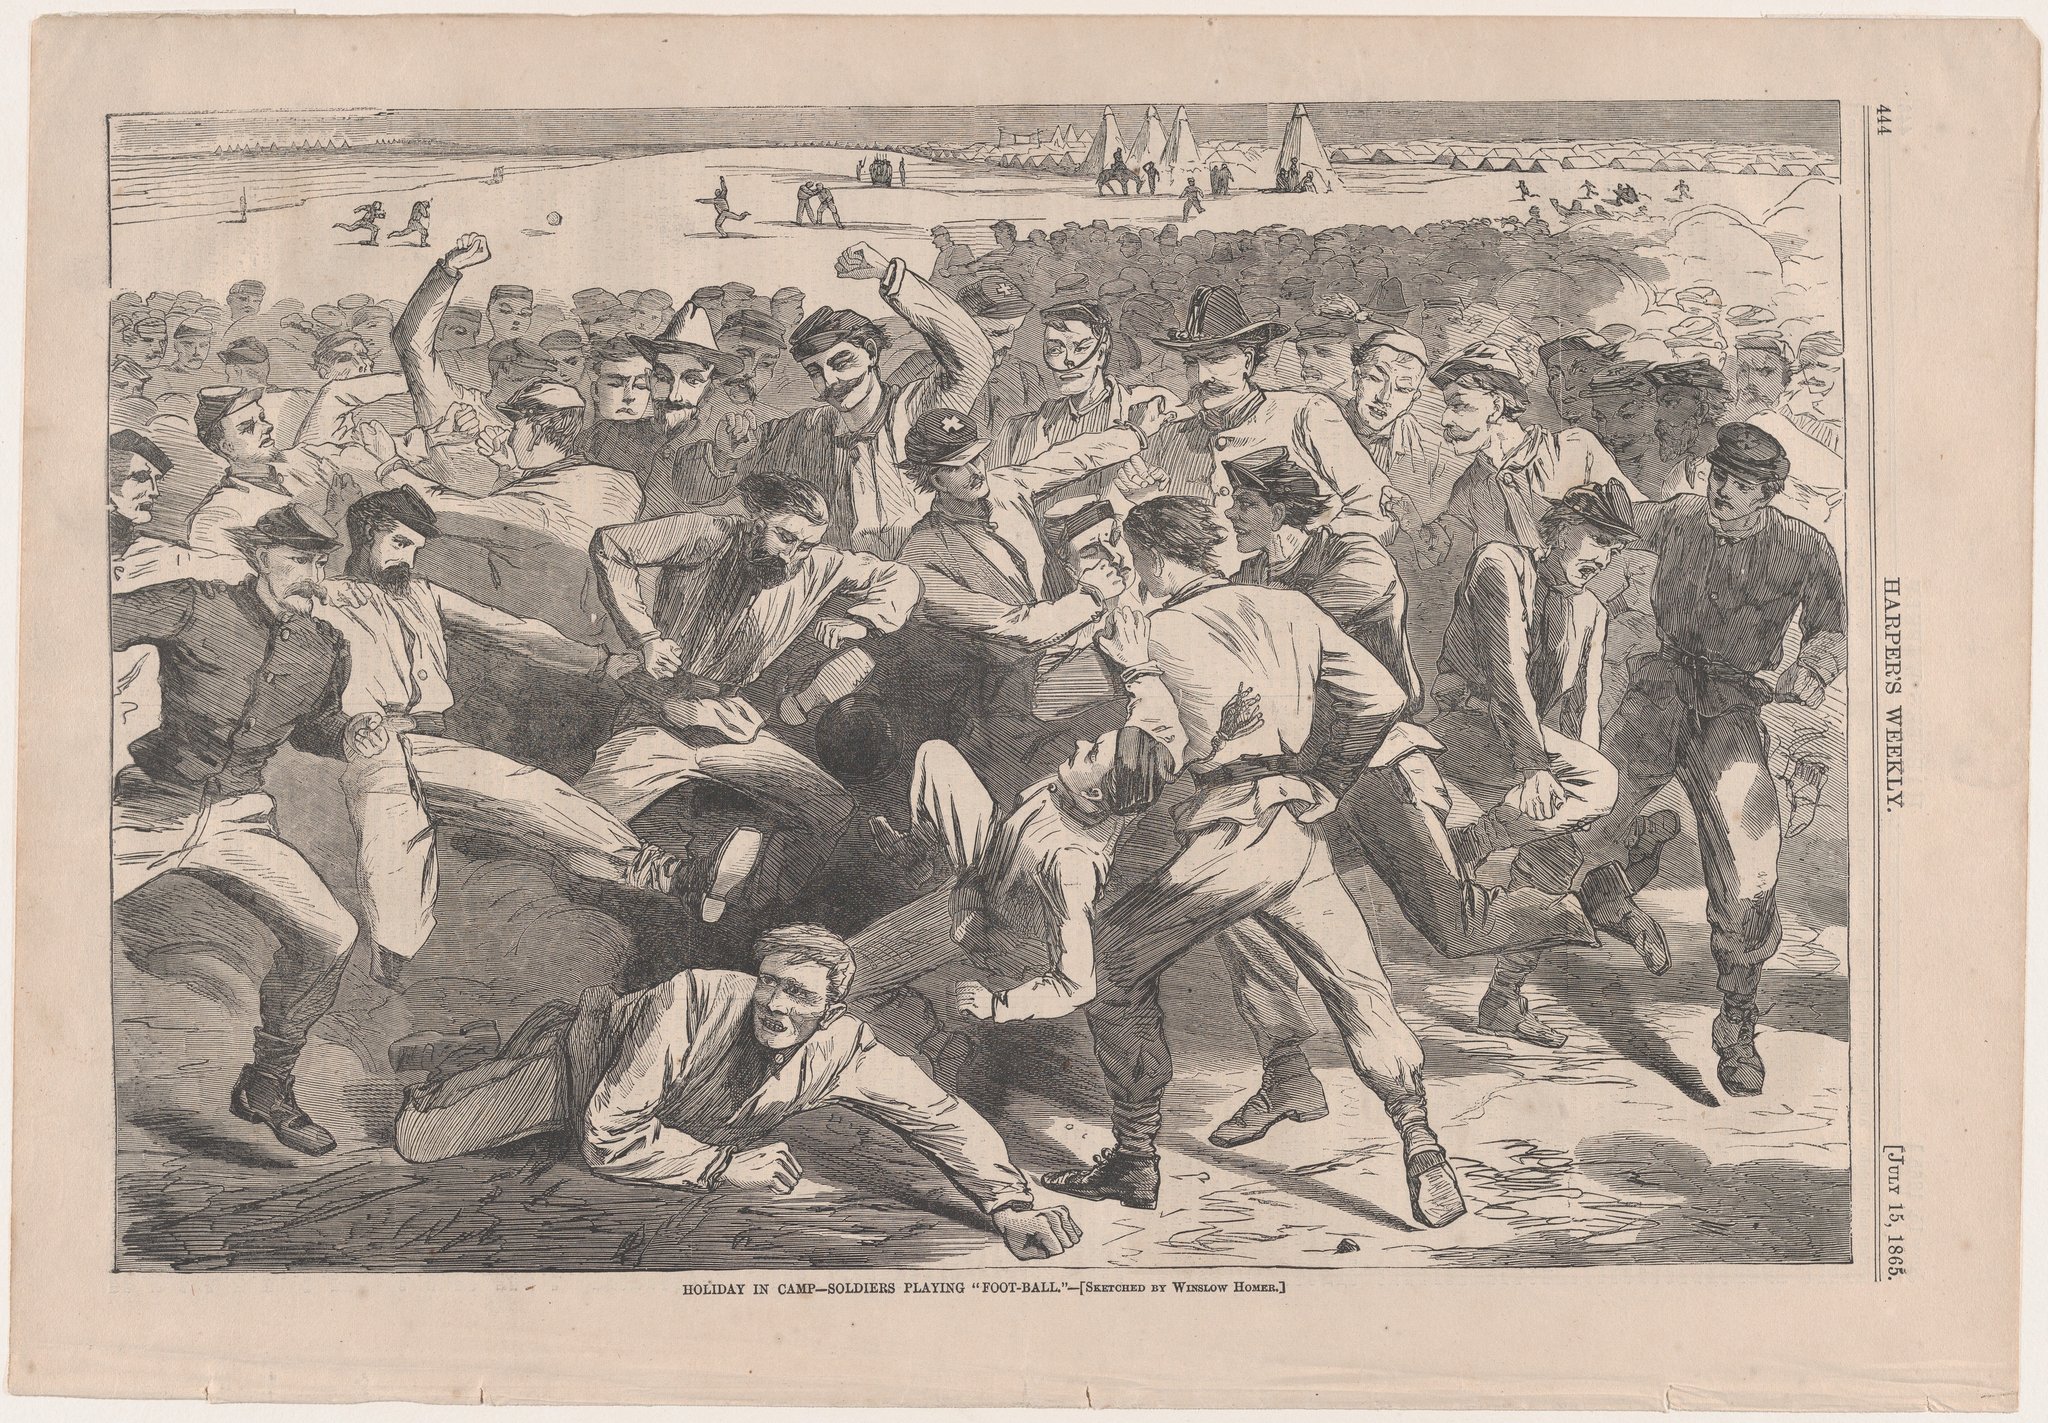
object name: print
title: Holiday in Camp – Soldiers Playing "Foot-Ball" – Sketched by Winslow Homer (from "Harper's Weekly," Vol. IX)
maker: winslow homer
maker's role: artist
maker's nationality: american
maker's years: 1836-1910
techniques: engraving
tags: soldiers,american civil war,men